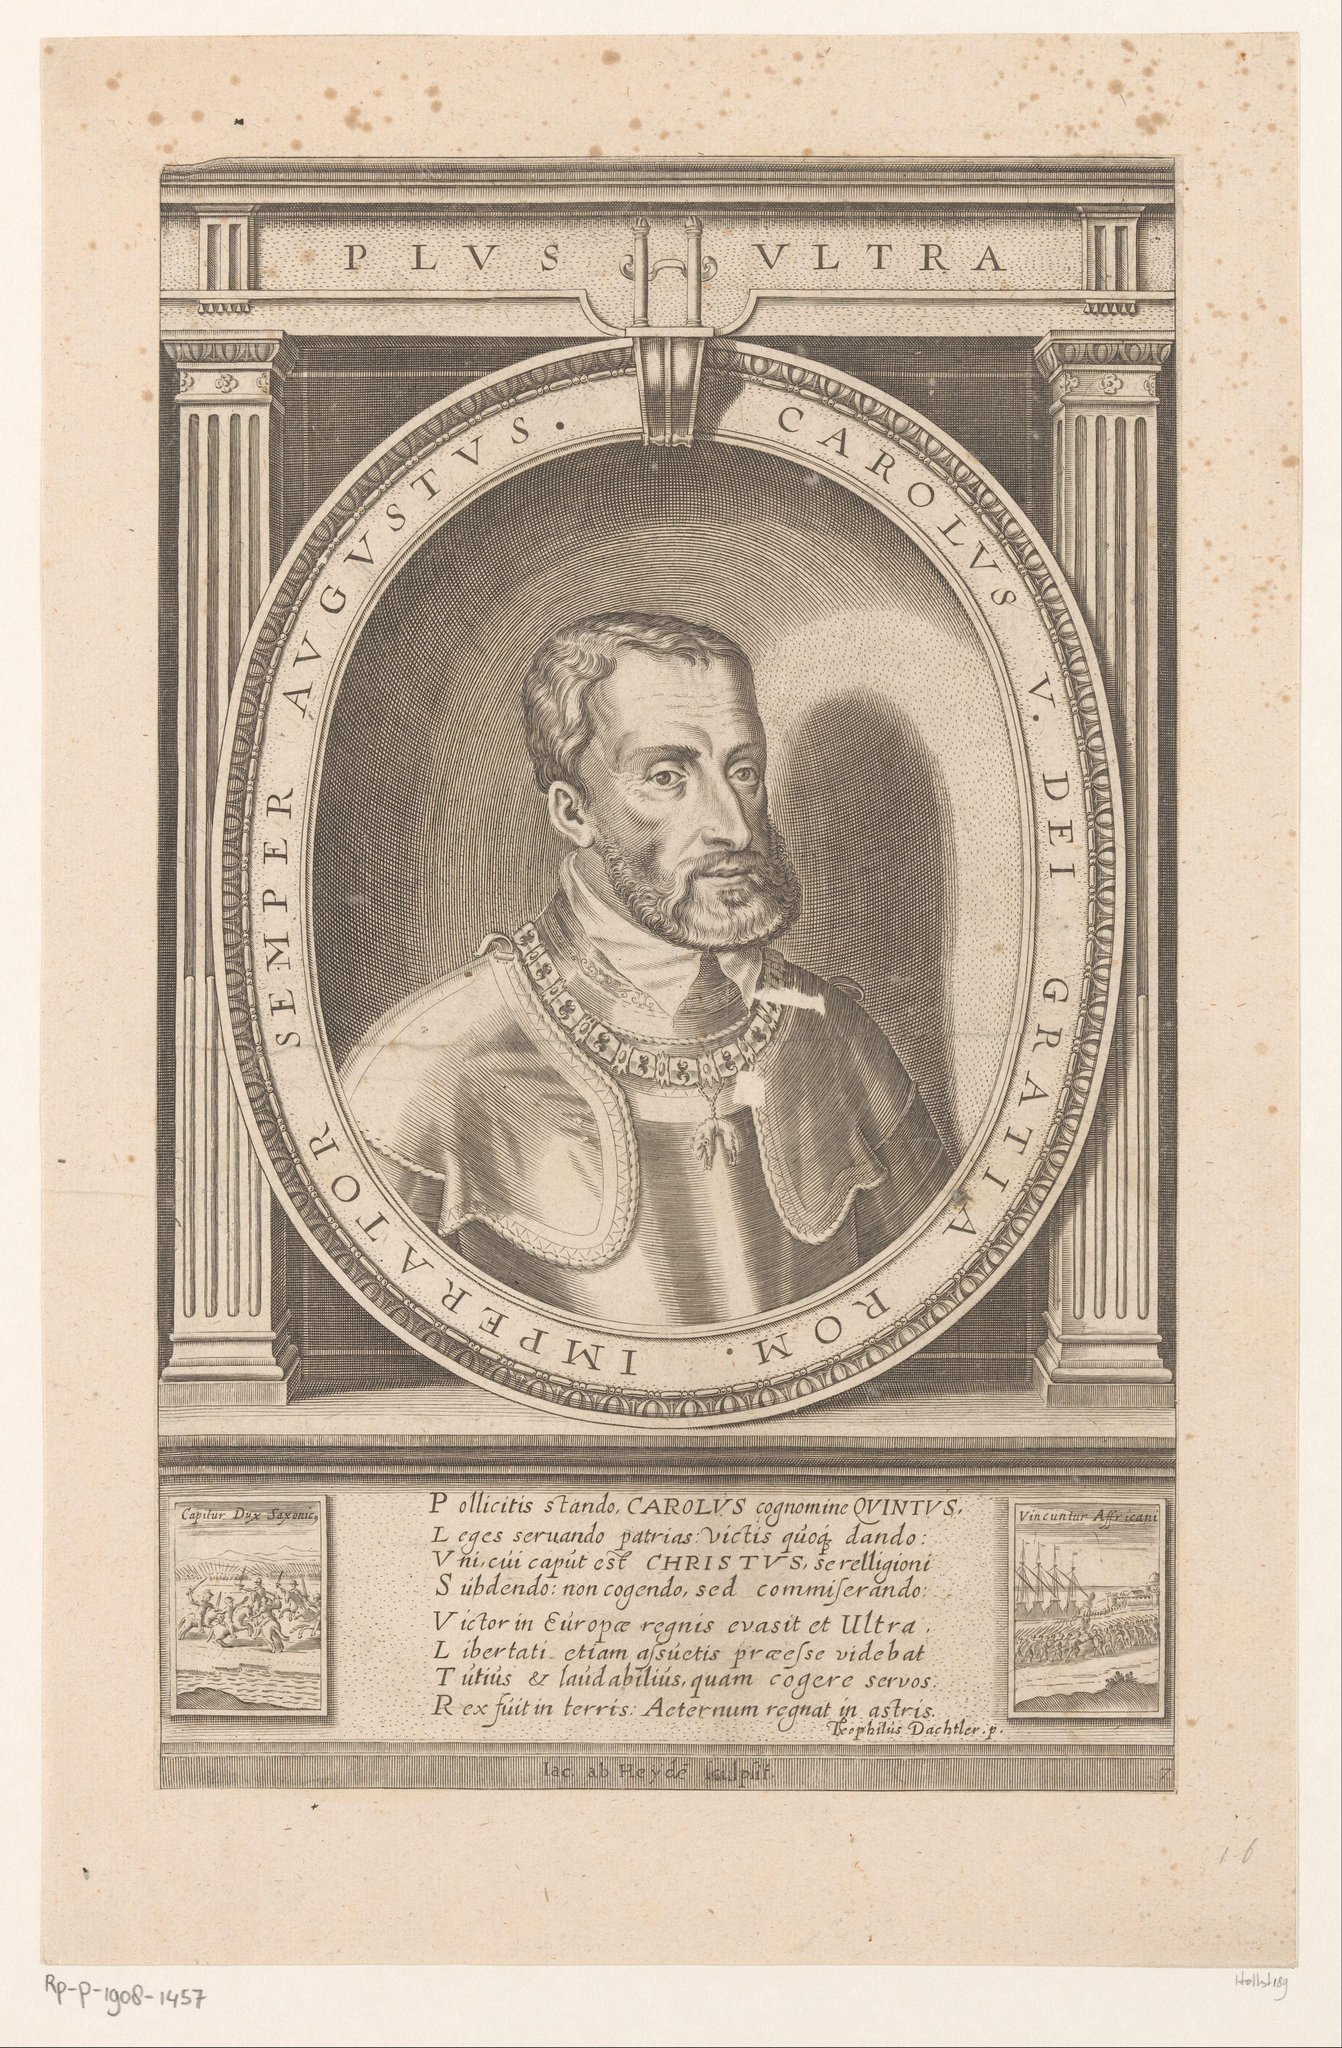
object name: book illustration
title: Portret van keizer Karel V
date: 1660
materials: paper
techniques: engraving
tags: ghent, charles v (holy roman emperor and king of spain), historical persons, battle, ruler, sovereign, knighthood order of the golden fleece - insignia of a knighthood order, e.g.: badge, chain (with name of order)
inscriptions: collector's mark: Lugt 2228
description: Prent uit: Aquila Austriaca Das ist Historische Beschreibung und Abbildungen Aller Römischen Kaiser und Könige (...). Neurenberg: Paul Fürst, [1660].